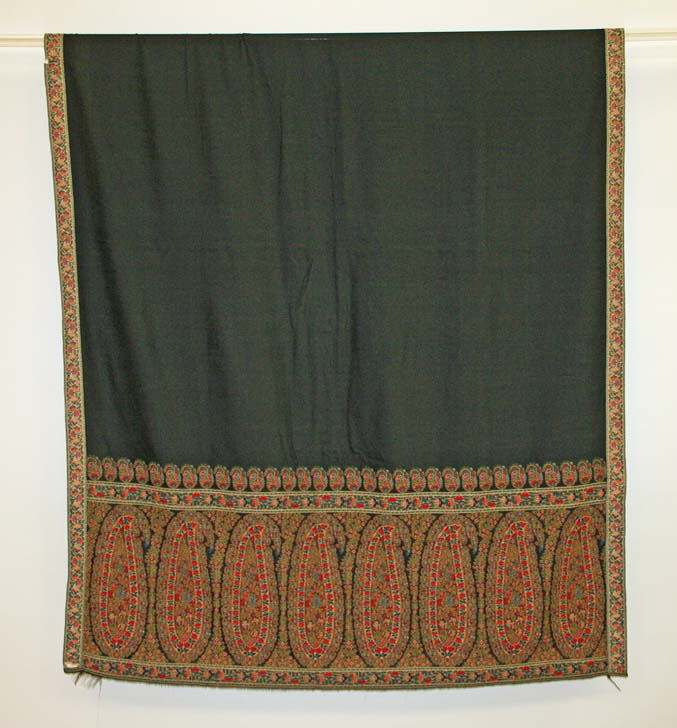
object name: shawl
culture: european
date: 1815-1820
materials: cotton, silk